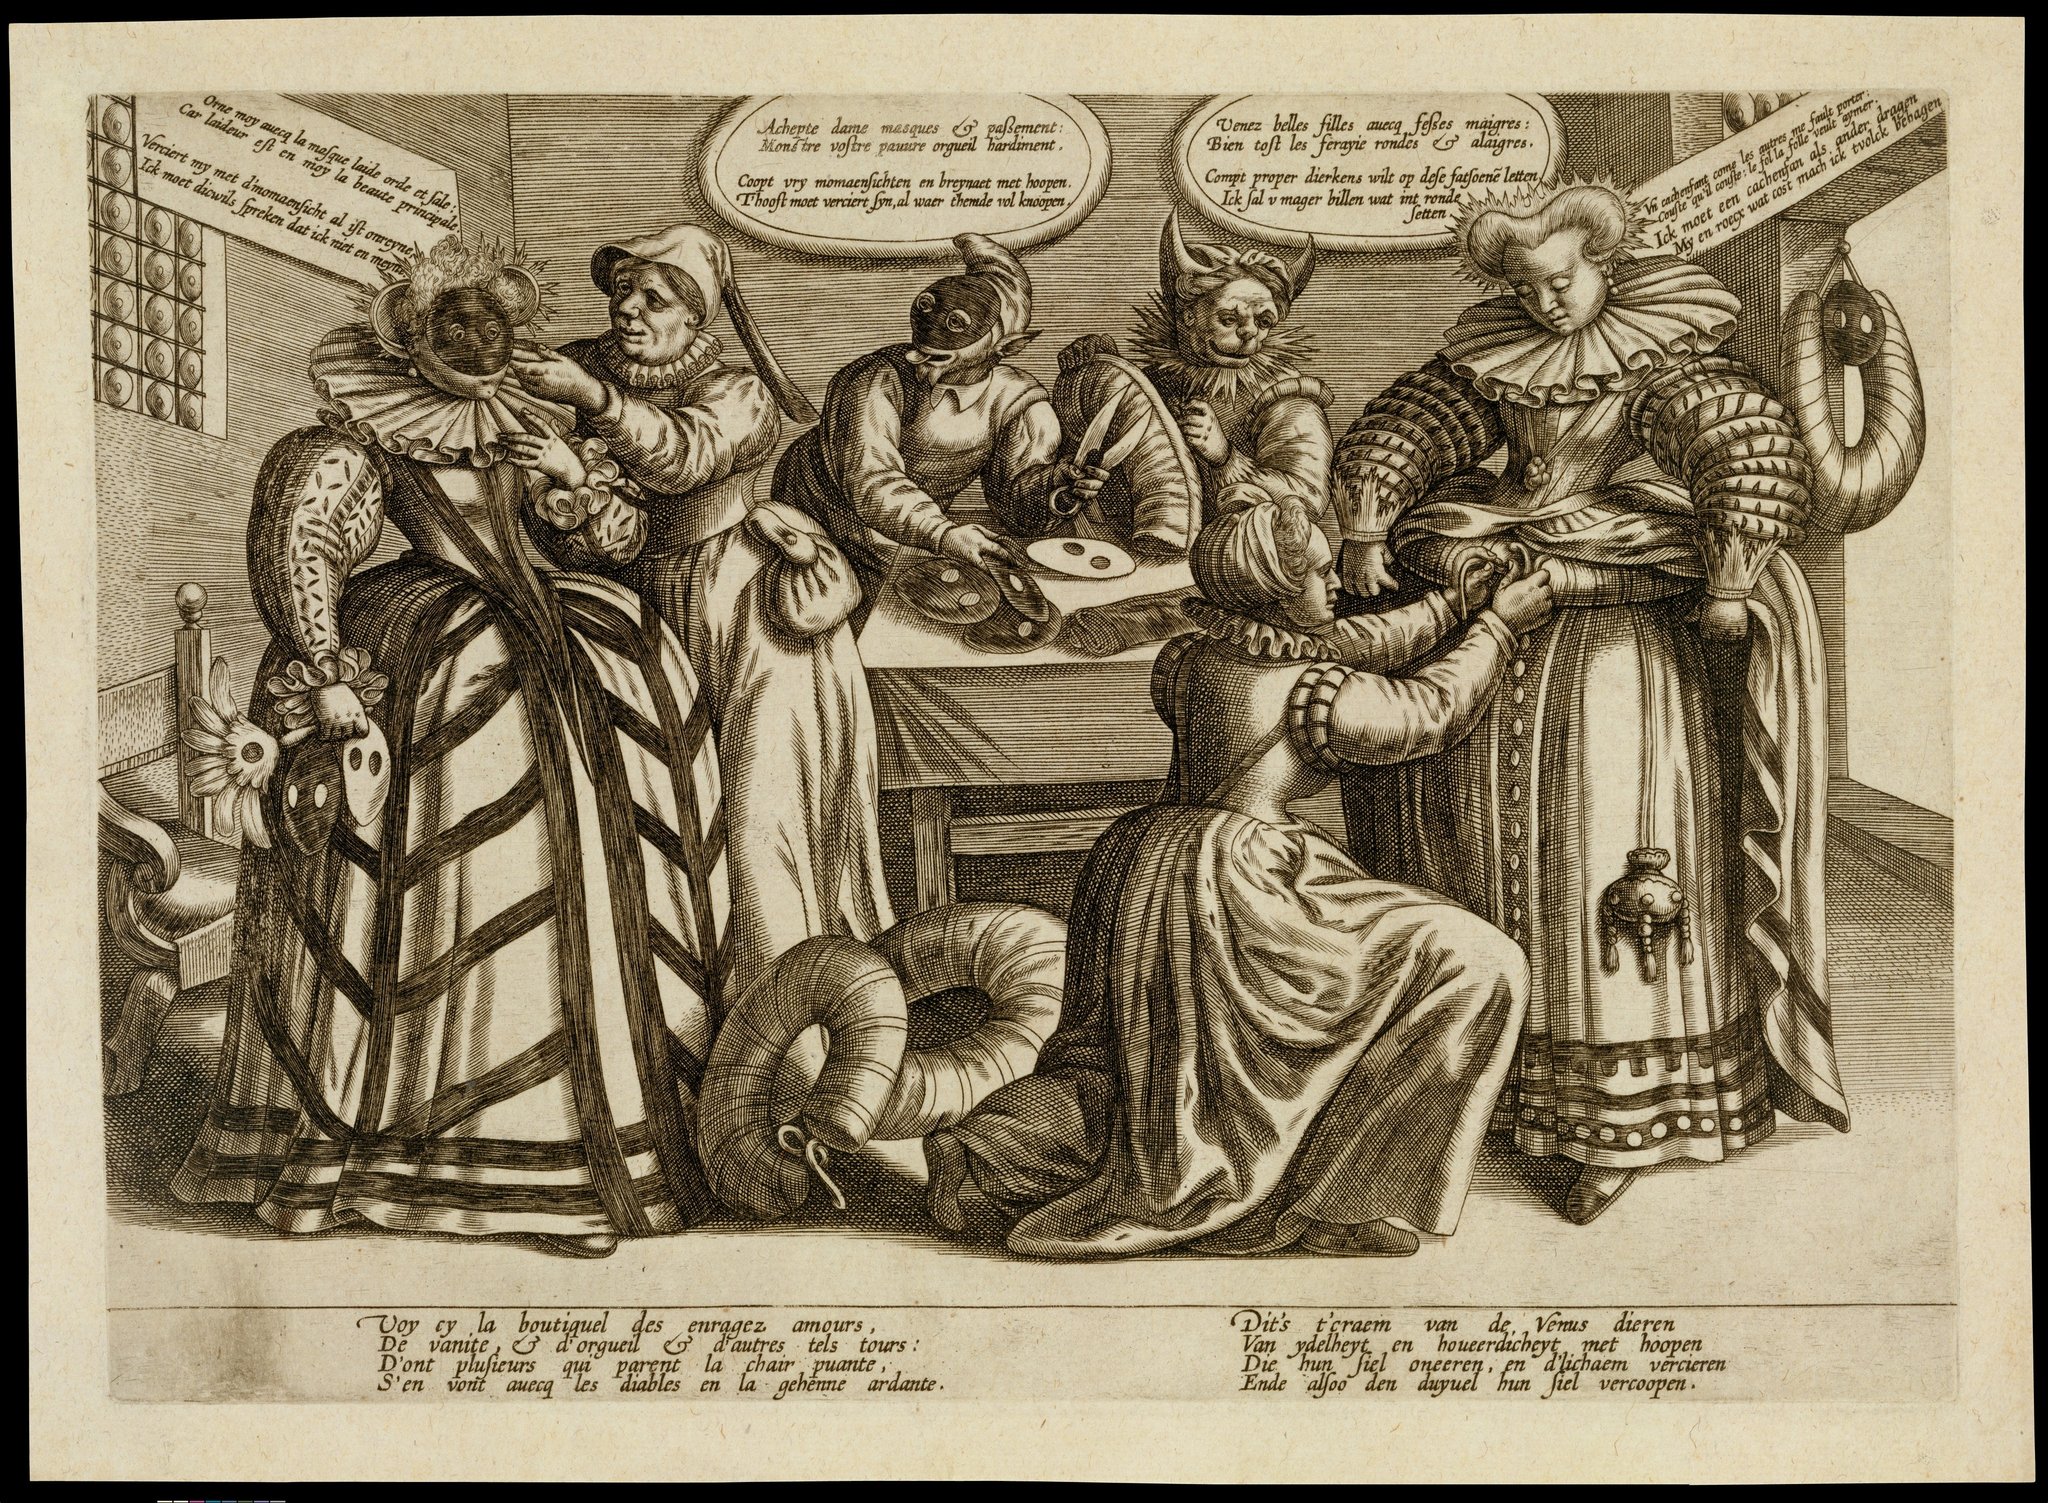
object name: engraving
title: The Vanity of Women: Masks and Bustles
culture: dutch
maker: maerten de vos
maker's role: artist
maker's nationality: netherlandish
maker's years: 1532-1603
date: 1600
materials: paper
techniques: engraving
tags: masks